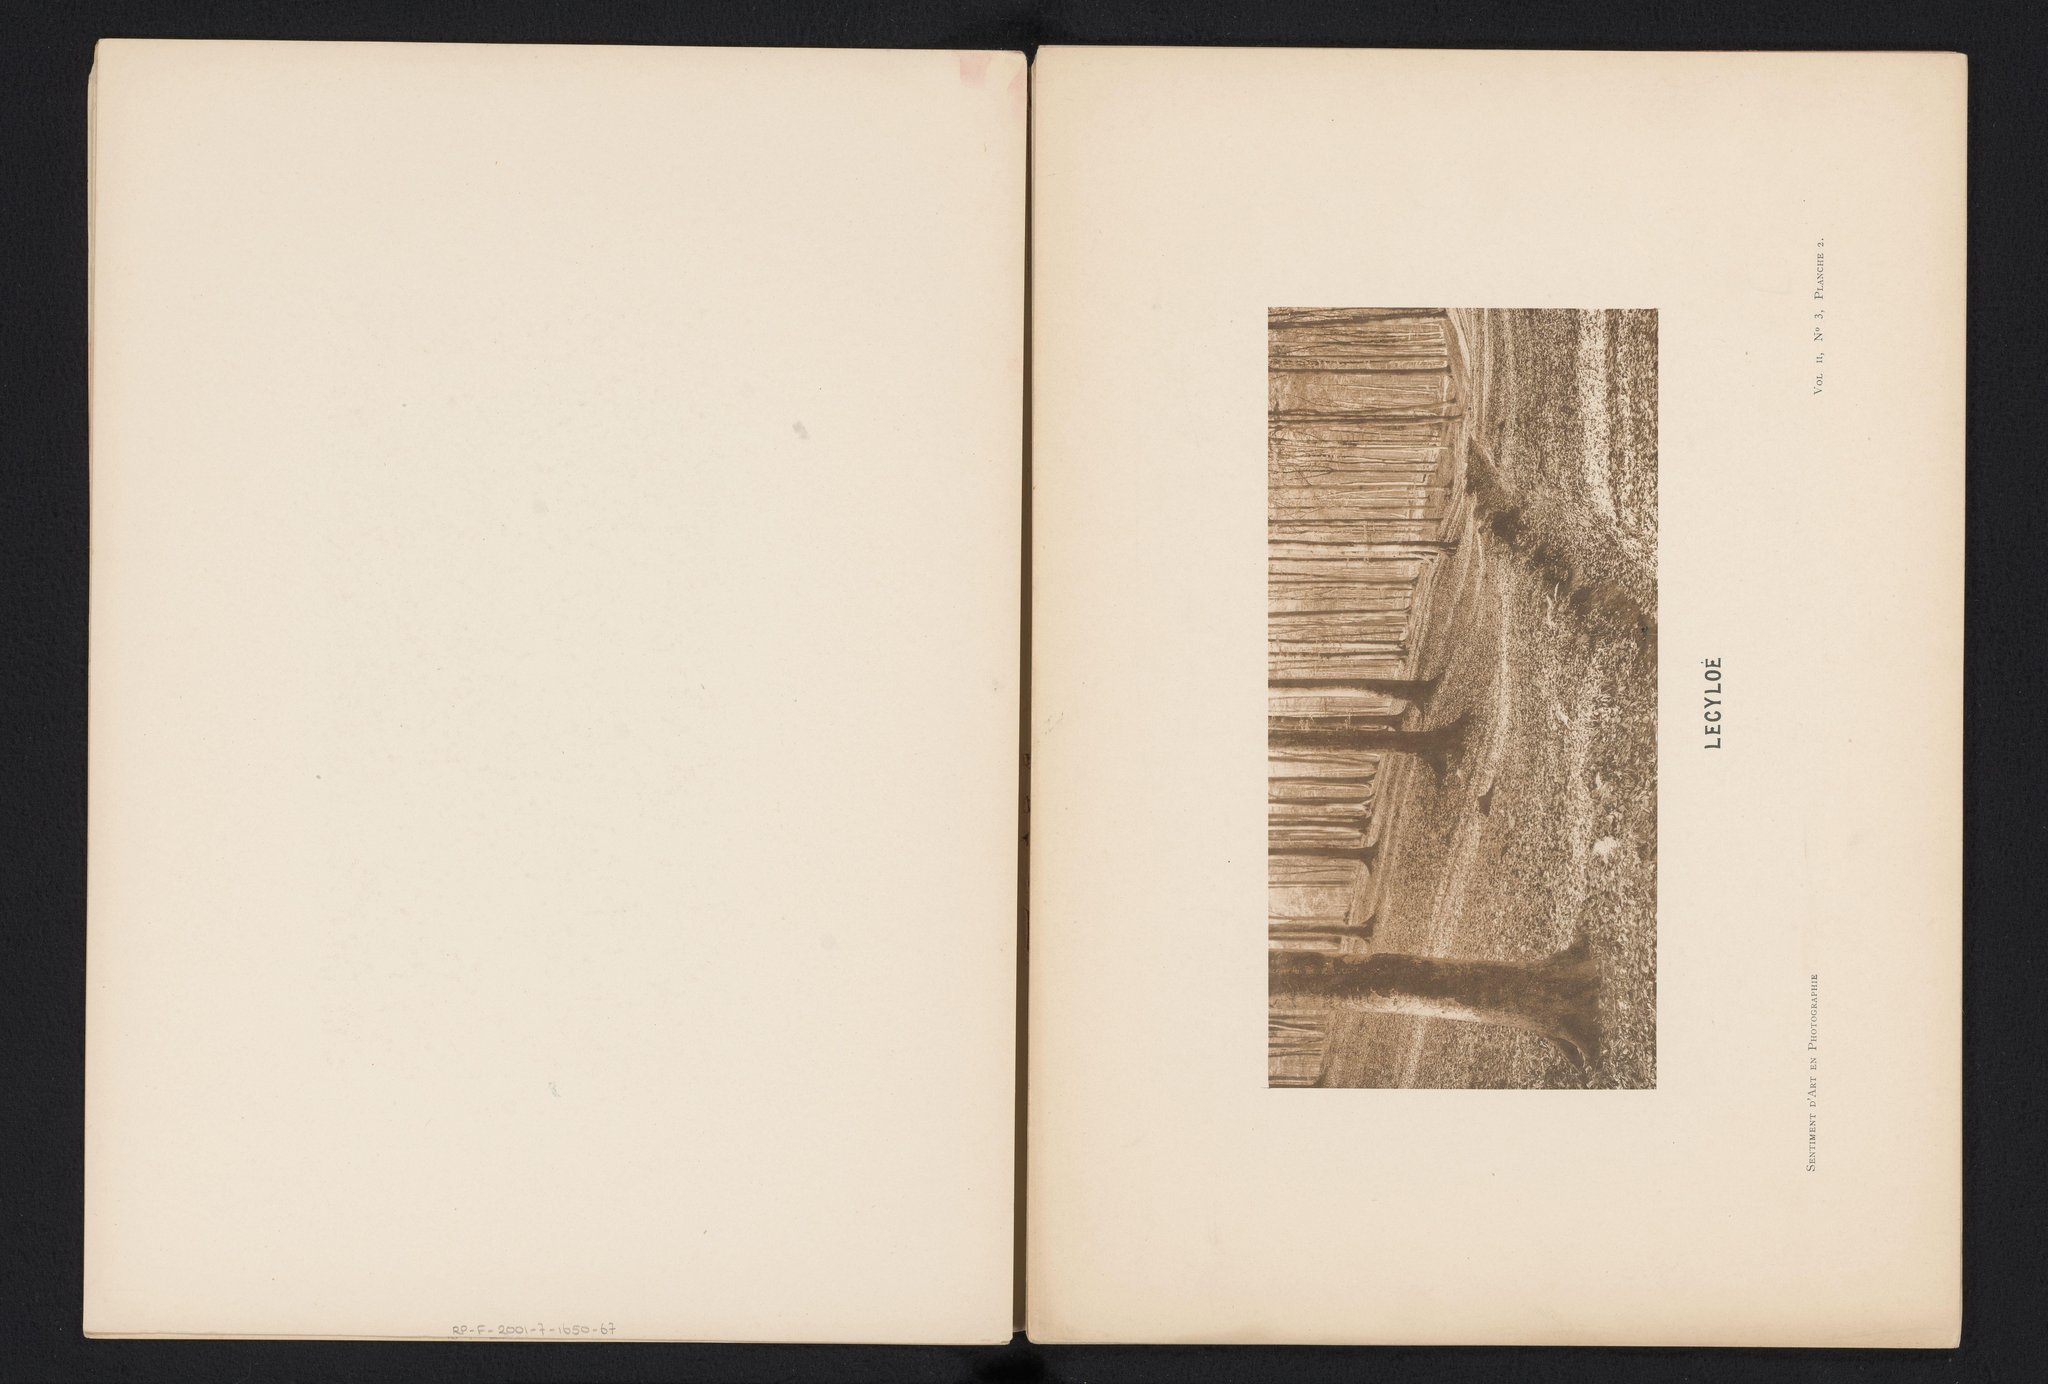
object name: photomechanical print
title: Bos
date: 1895-1900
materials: paper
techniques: photograph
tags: forest, wood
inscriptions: number: ‘Vol. II, No 3, Planche 2.’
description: Deze prent maakt deel uit van 8 omslagen met 22 tekstbladen en 89 prenten op losse bladen in en tussen de omslagen.